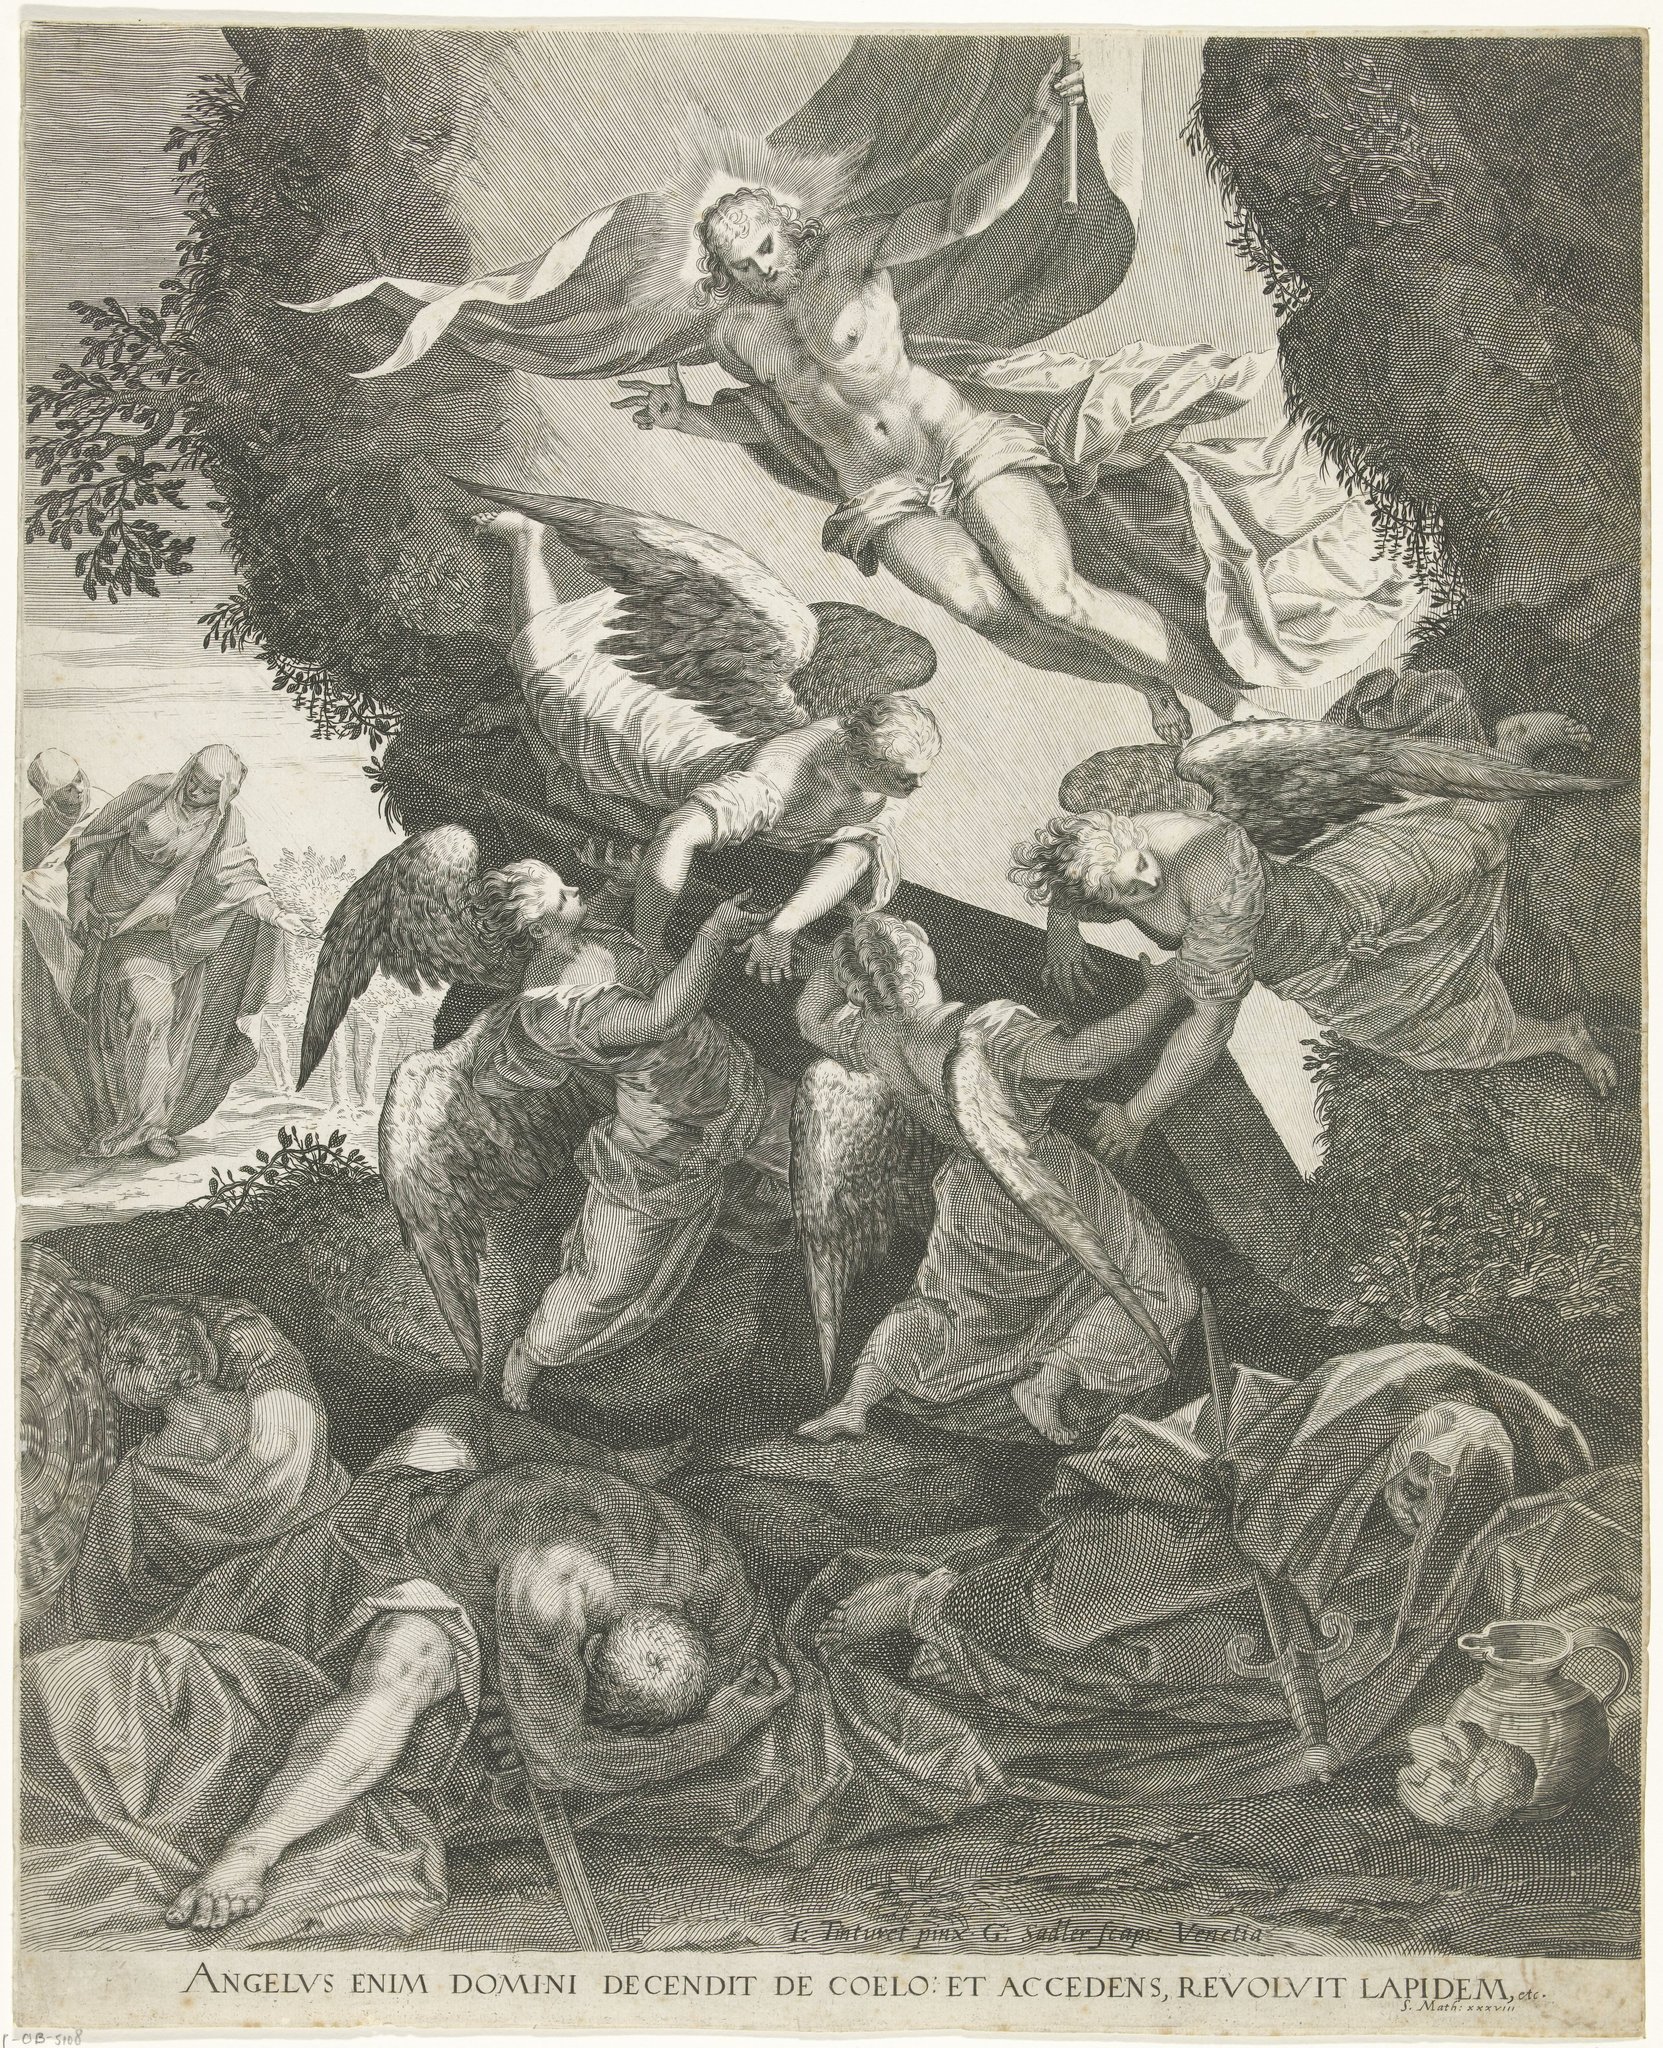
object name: print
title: Opstanding van Christus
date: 1593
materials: paper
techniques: engraving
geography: venice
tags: christ, usually holding a banner, arises from the grave; often combined with sleeping and/or frightened soldiers (+ angel(s)), the holy women (the three maries) on their way to or at the tomb, to anoint christ's body, angel(s) opening the tomb of christ, e.g.: by rolling aside the stone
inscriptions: collector's mark: Lugt 240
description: Vier engelen openen het deksel van de graftombe. Christus verrijst uit zijn graf. De soldaten liggen rondom zijn graf in diepe slaap. Links de aankomst van de drie heilige vrouwen bij het graf. De prent heeft een Latijns onderschrift.